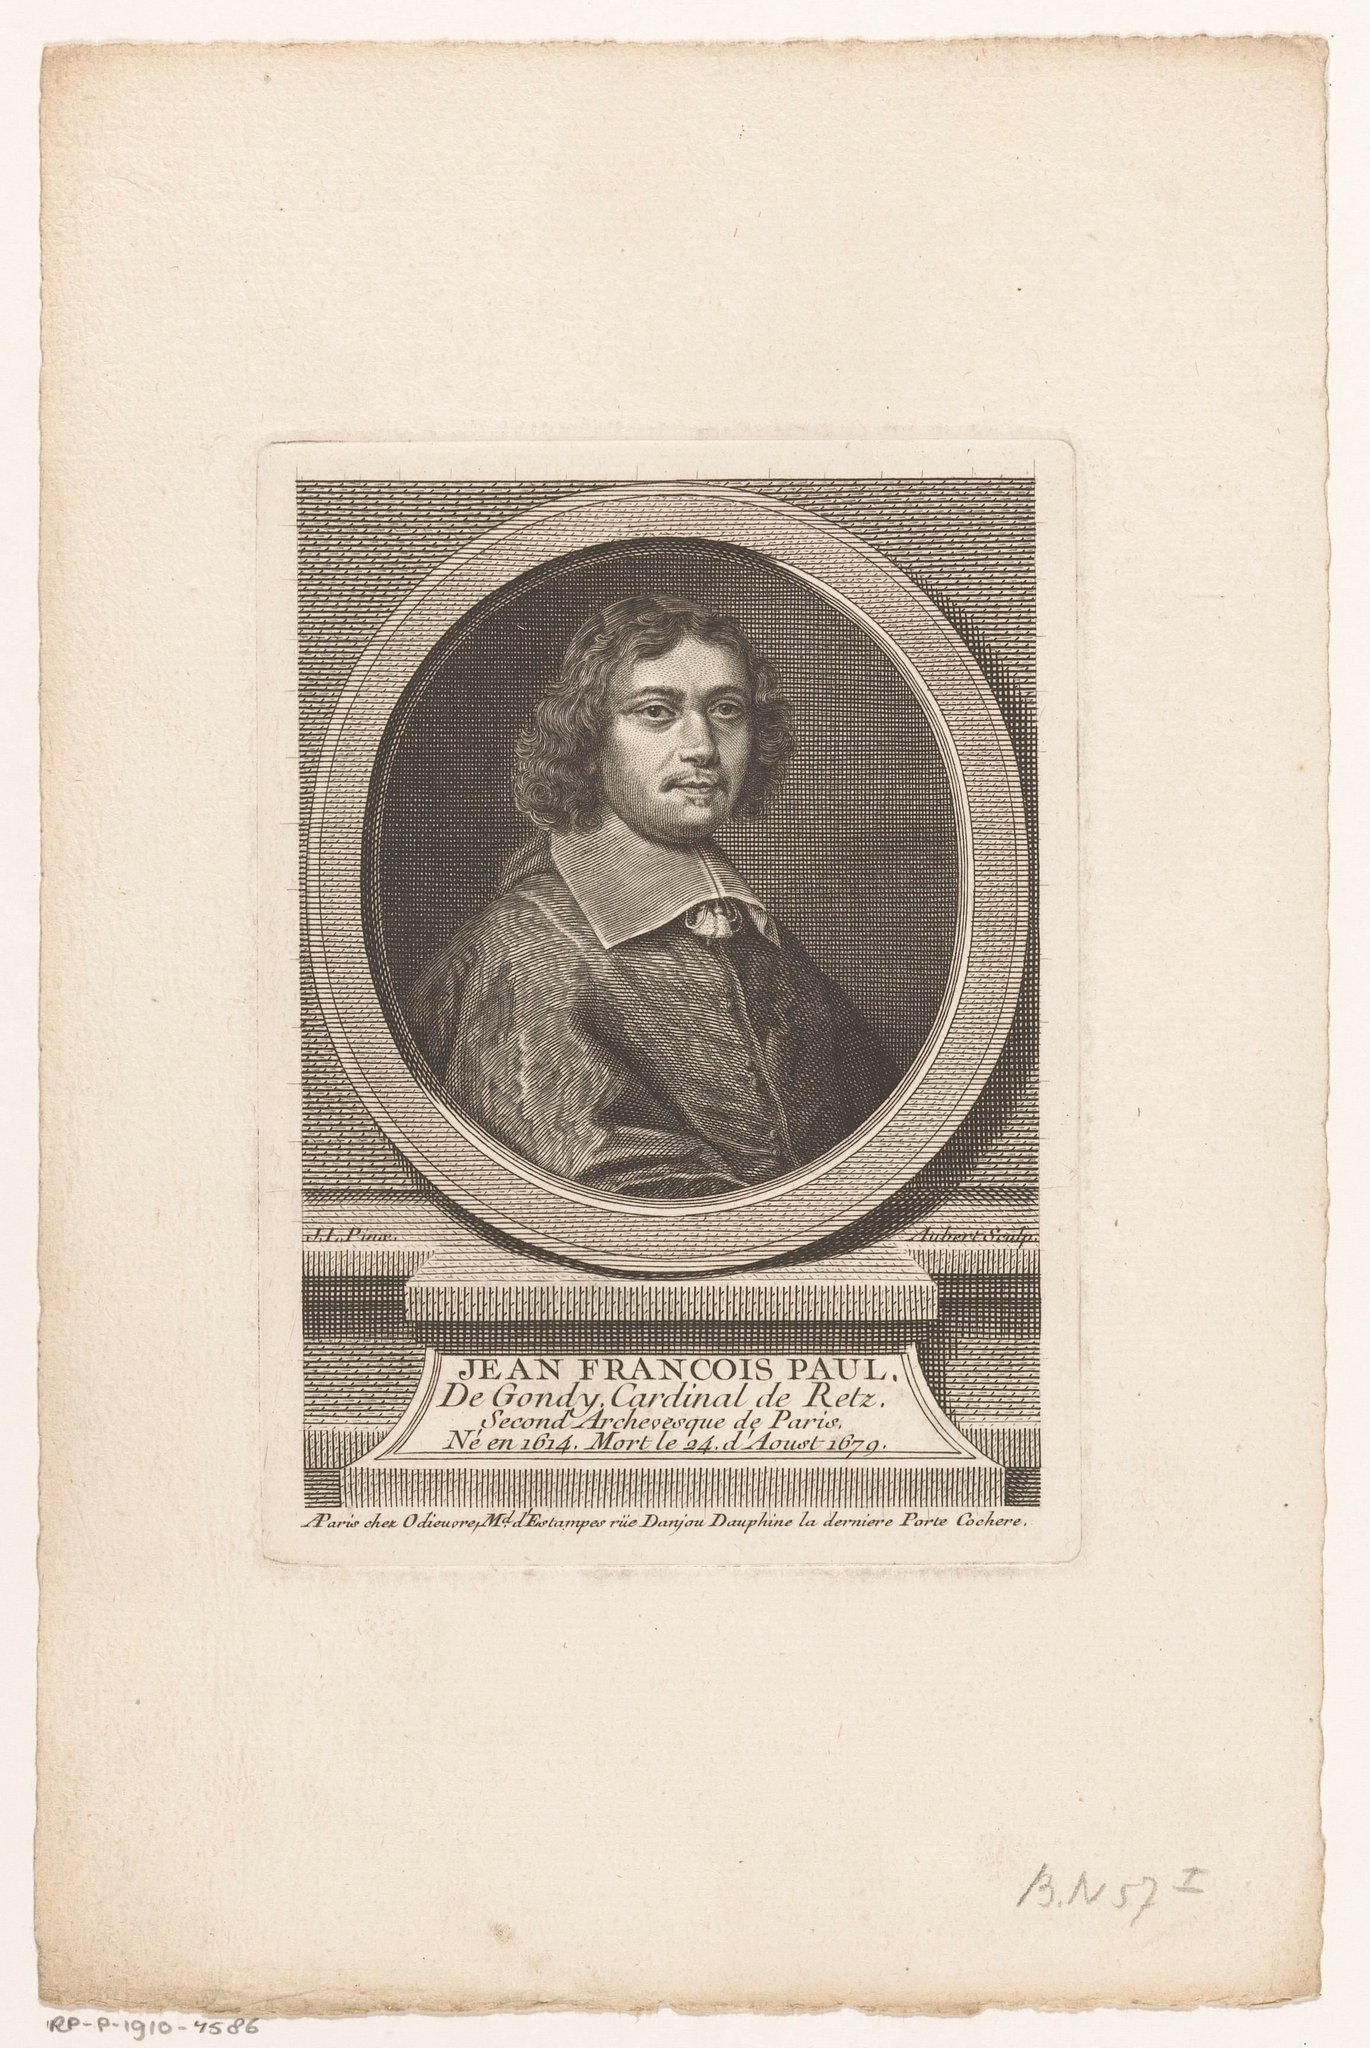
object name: print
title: Jean Francois Paul De Gony, Cardinal de Retz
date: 1755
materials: paper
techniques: engraving, etching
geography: paris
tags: historical persons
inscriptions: collector's mark: Lugt 2228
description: Prent uit M. Dreux du Radier. L'Europe illustre, contenant l'histoire abregée (...). Parijs: M. Oudrieuve, A.-F. Le Breton, 1755.